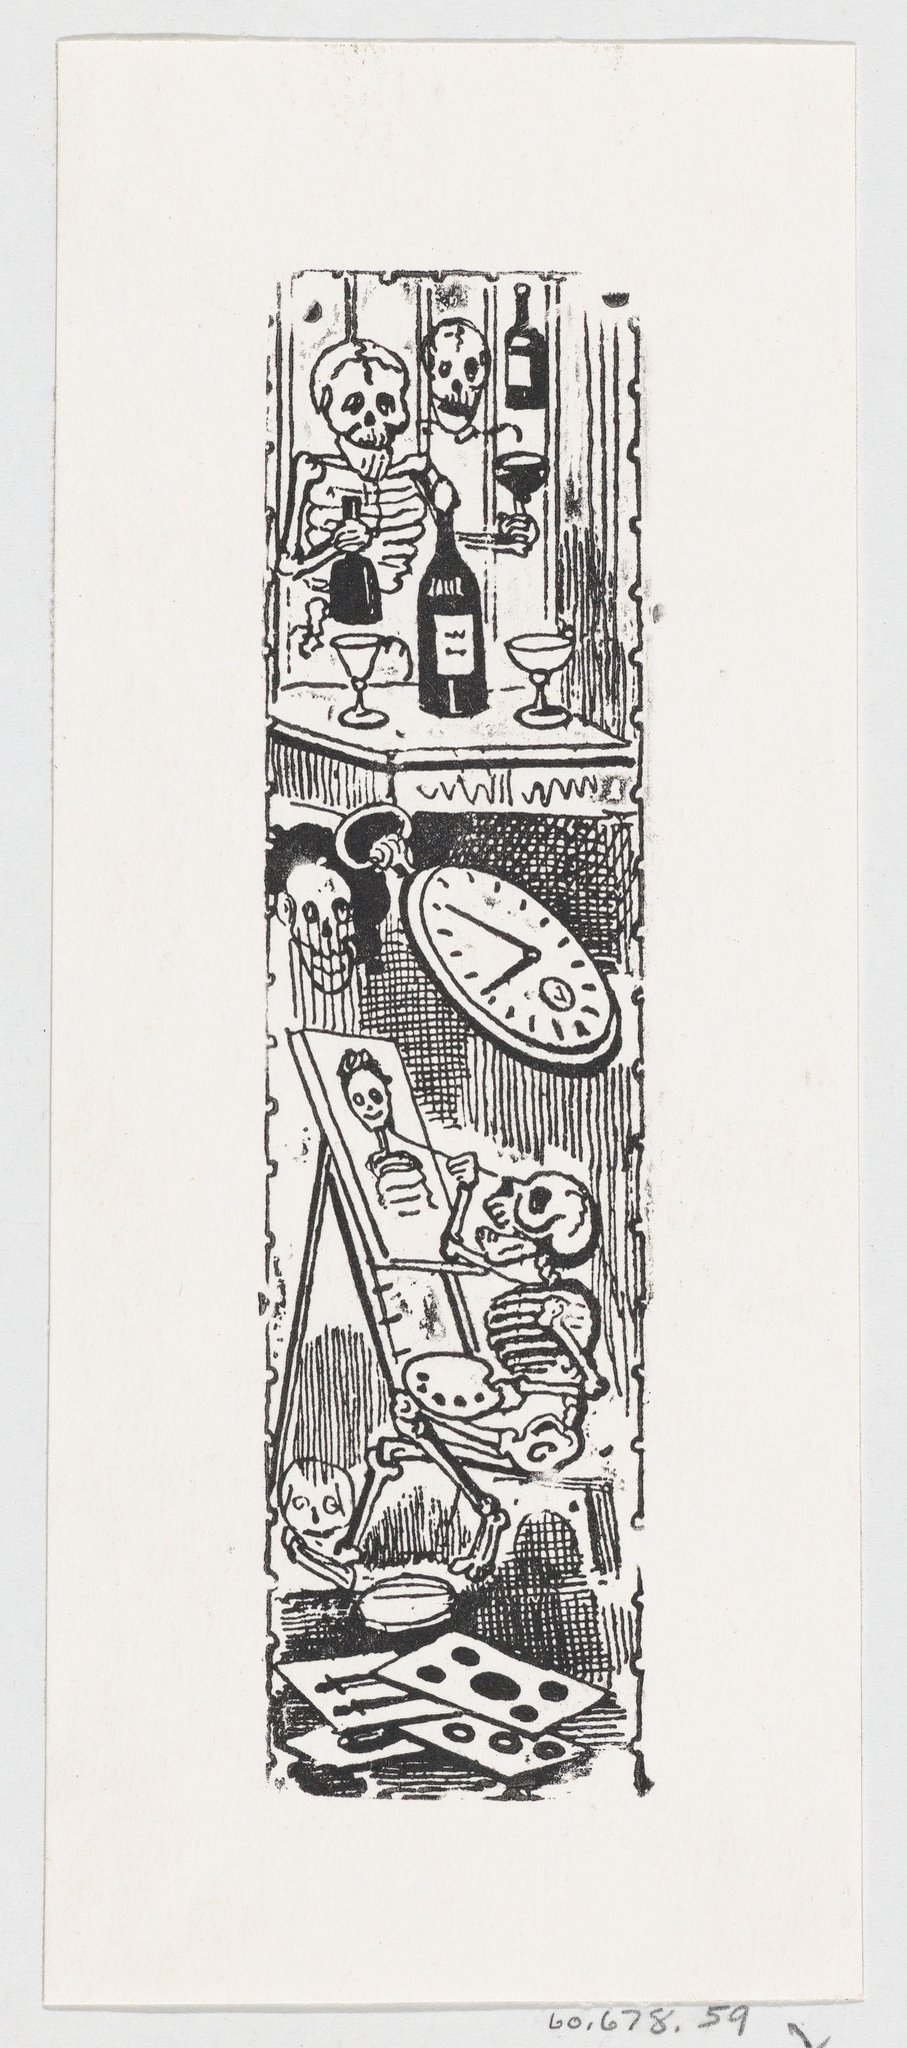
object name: print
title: A skeleton painting and another skeleton holding a bottle of liquor, from a broadside entitled 'Aqui esta la calavera del editor popular'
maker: josé guadalupe posada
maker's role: artist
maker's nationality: mexican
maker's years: 1852-1913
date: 1880-1910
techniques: lithography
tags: painting,skeletons,bottles,clocks